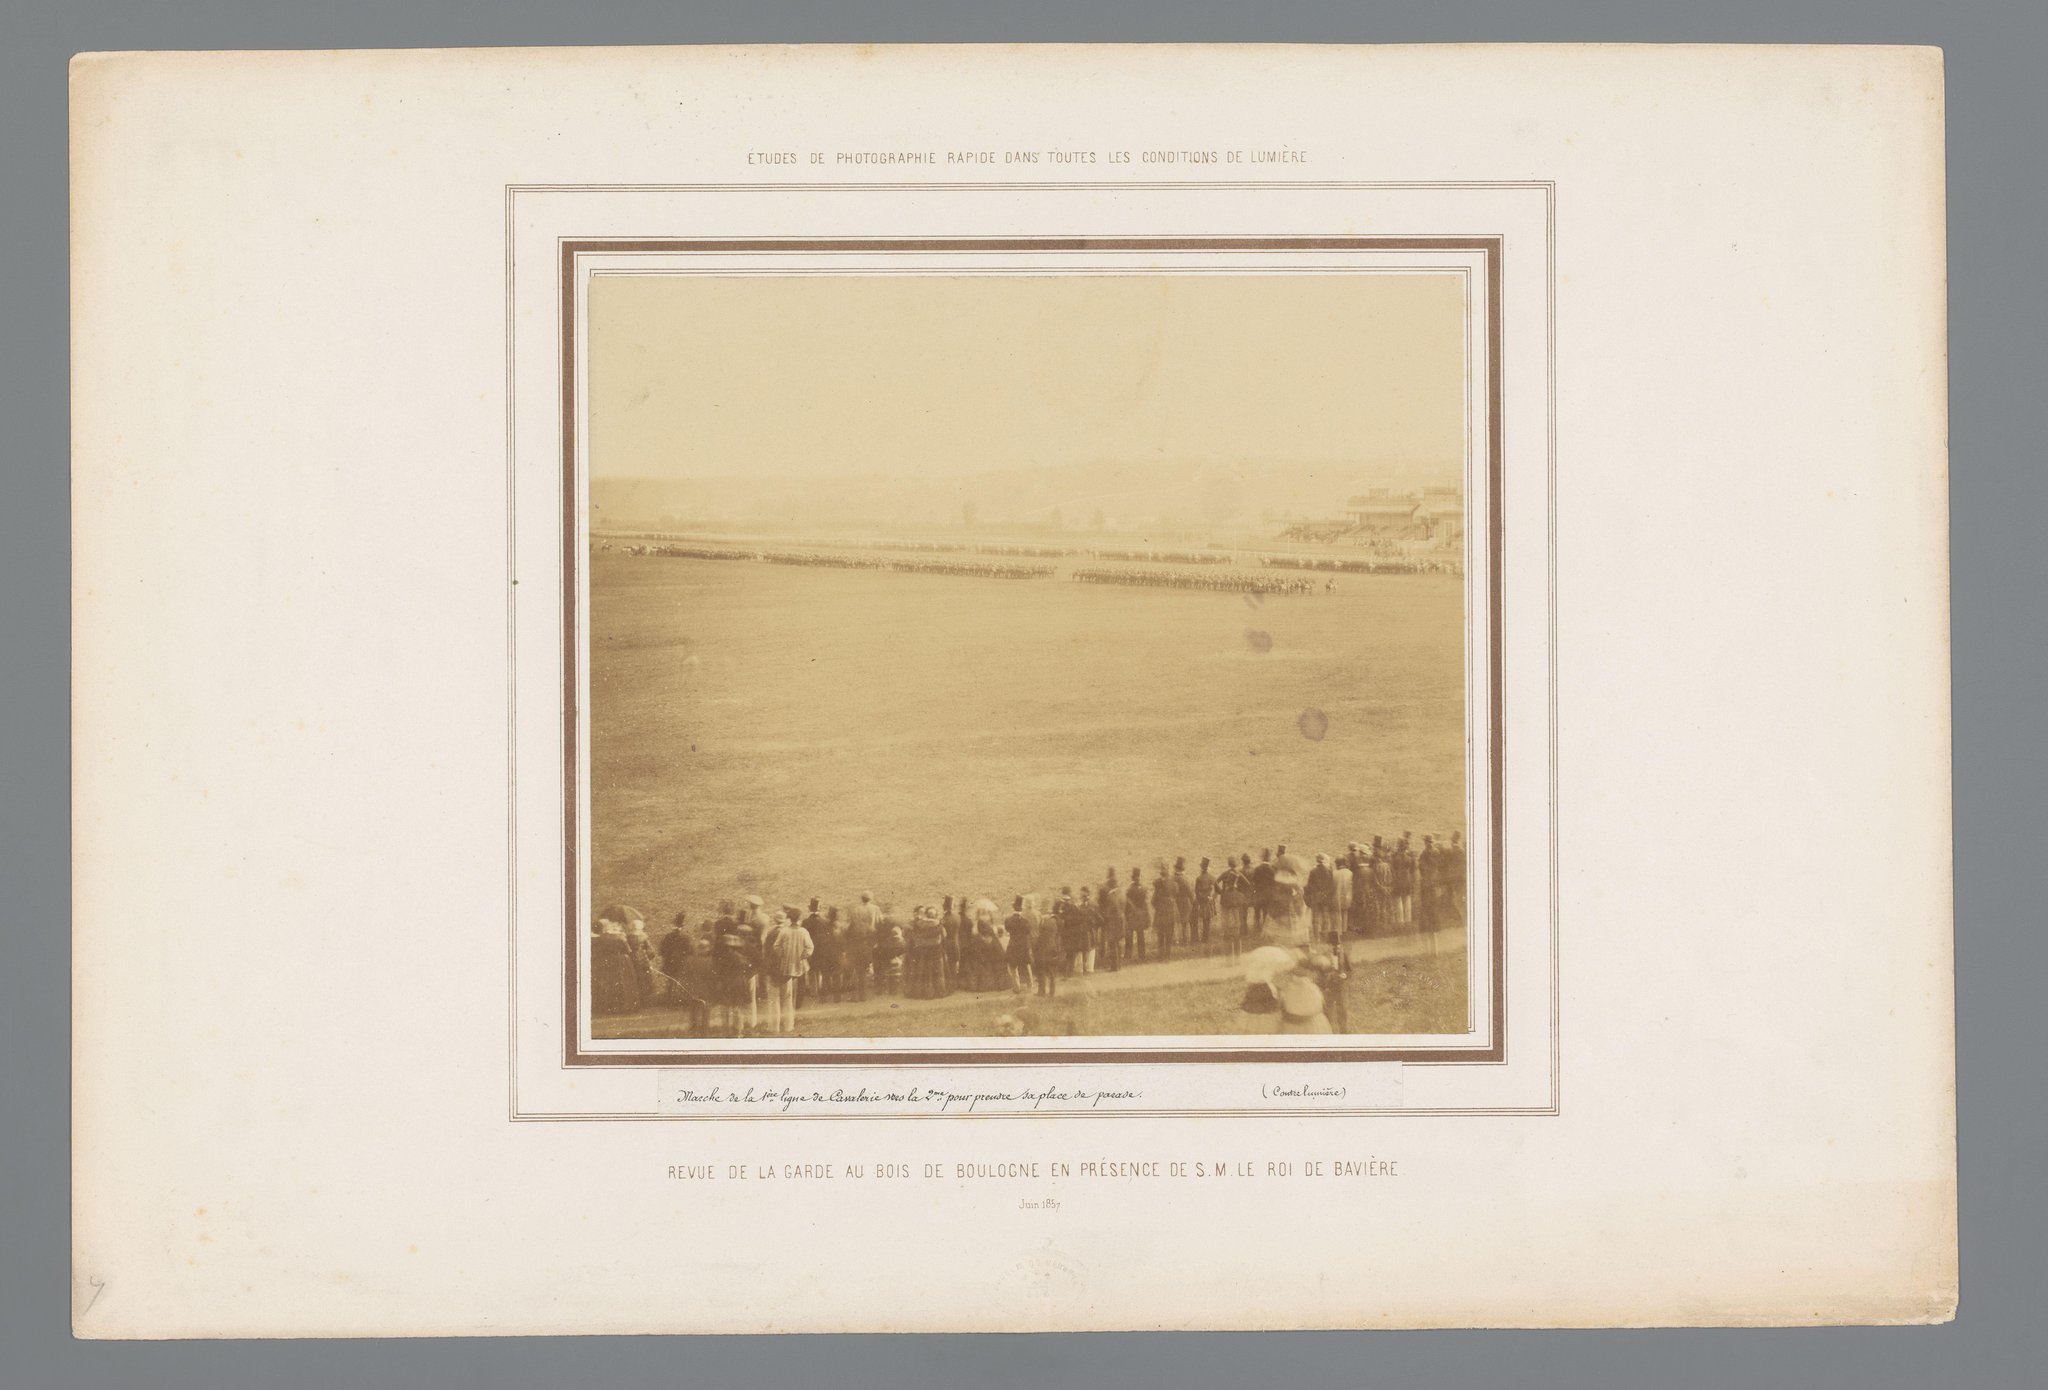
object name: photograph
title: Wisseling van de wacht in het Bois de Boulogne te Parijs in het bijzijn van H.M. koning van Beieren, Frankrijk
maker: louis-pierre-théophile dubois de nehaut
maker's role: amateurfotograaf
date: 1806-1857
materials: cardboard, photographic support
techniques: salted paper print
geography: paris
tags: military parade, pageant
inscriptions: inscription: ‘Marche de la 1ère ligne de Cavalerie vers la 2me pour prendre sa place de parade (Contre lumière)’, inscription: ‘J.-F. DORÉ’, number: ‘7’